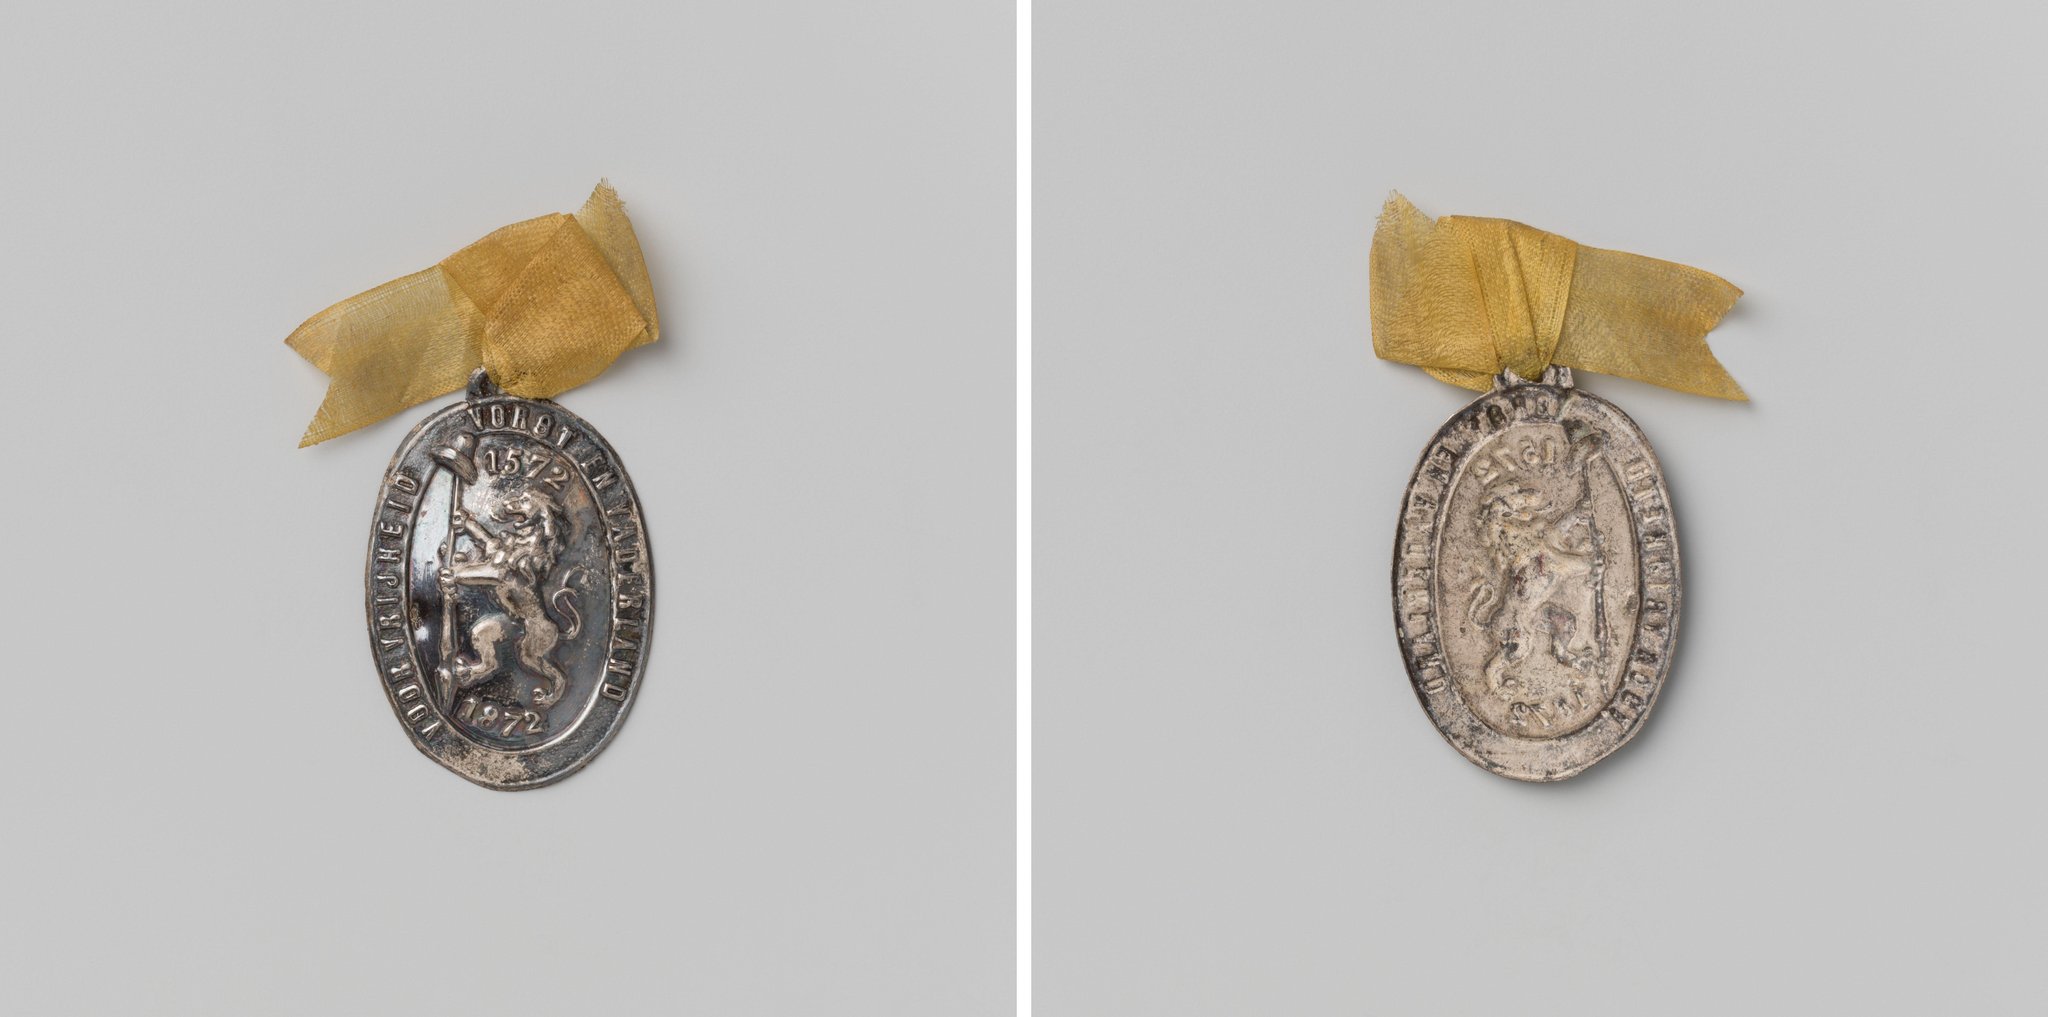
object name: insignia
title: Derde eeuwfeest van de inname van Den Briel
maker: Anonymous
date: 1873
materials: silver, textile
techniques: striking, weave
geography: netherlands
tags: brielle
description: Eenzijdig zilveren ovaal draagteken aan draagoog en gele strik. Voorzijde: staande leeuw naar links met in beide klauwen speer, waarop vrijheidshoed rust; boven en onder een jaartal binnen omschrift. Keerzijde: blanco.